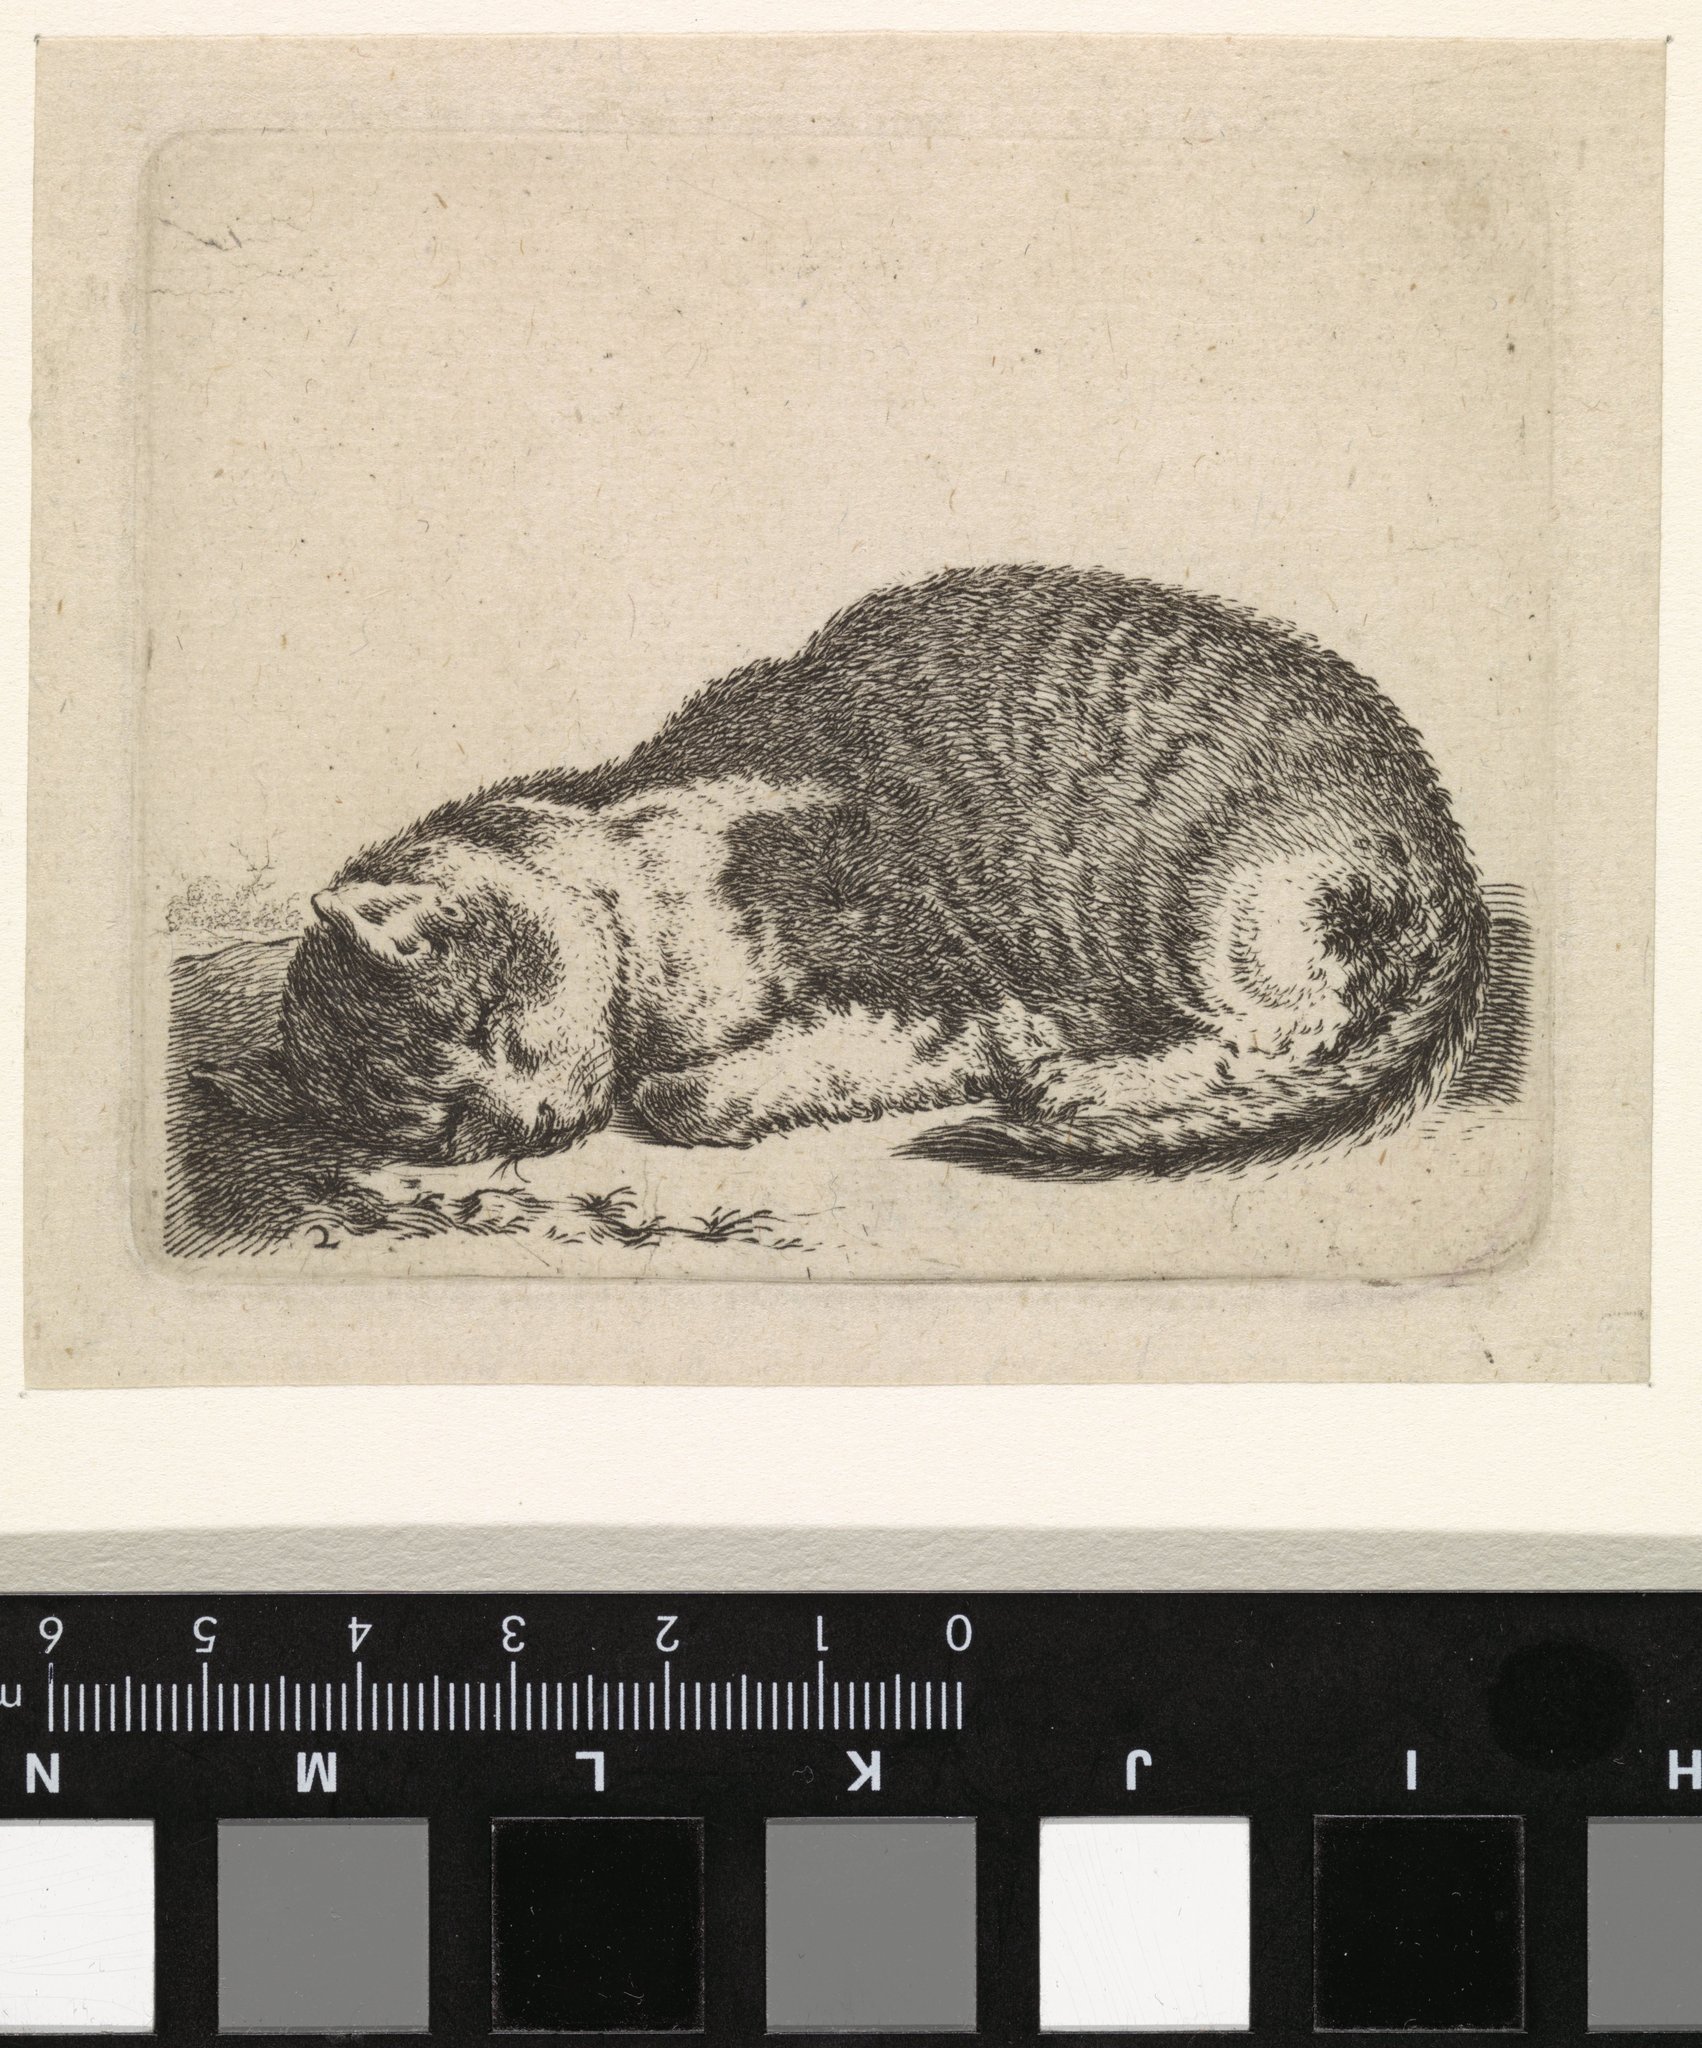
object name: print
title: Slapende poes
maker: cornelis saftleven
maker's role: draughtsman, painter, print maker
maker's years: 1607-1681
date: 1617-1681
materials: paper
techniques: etching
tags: cat, sleeping; unconsciousness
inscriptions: collector's mark: Lugt 240